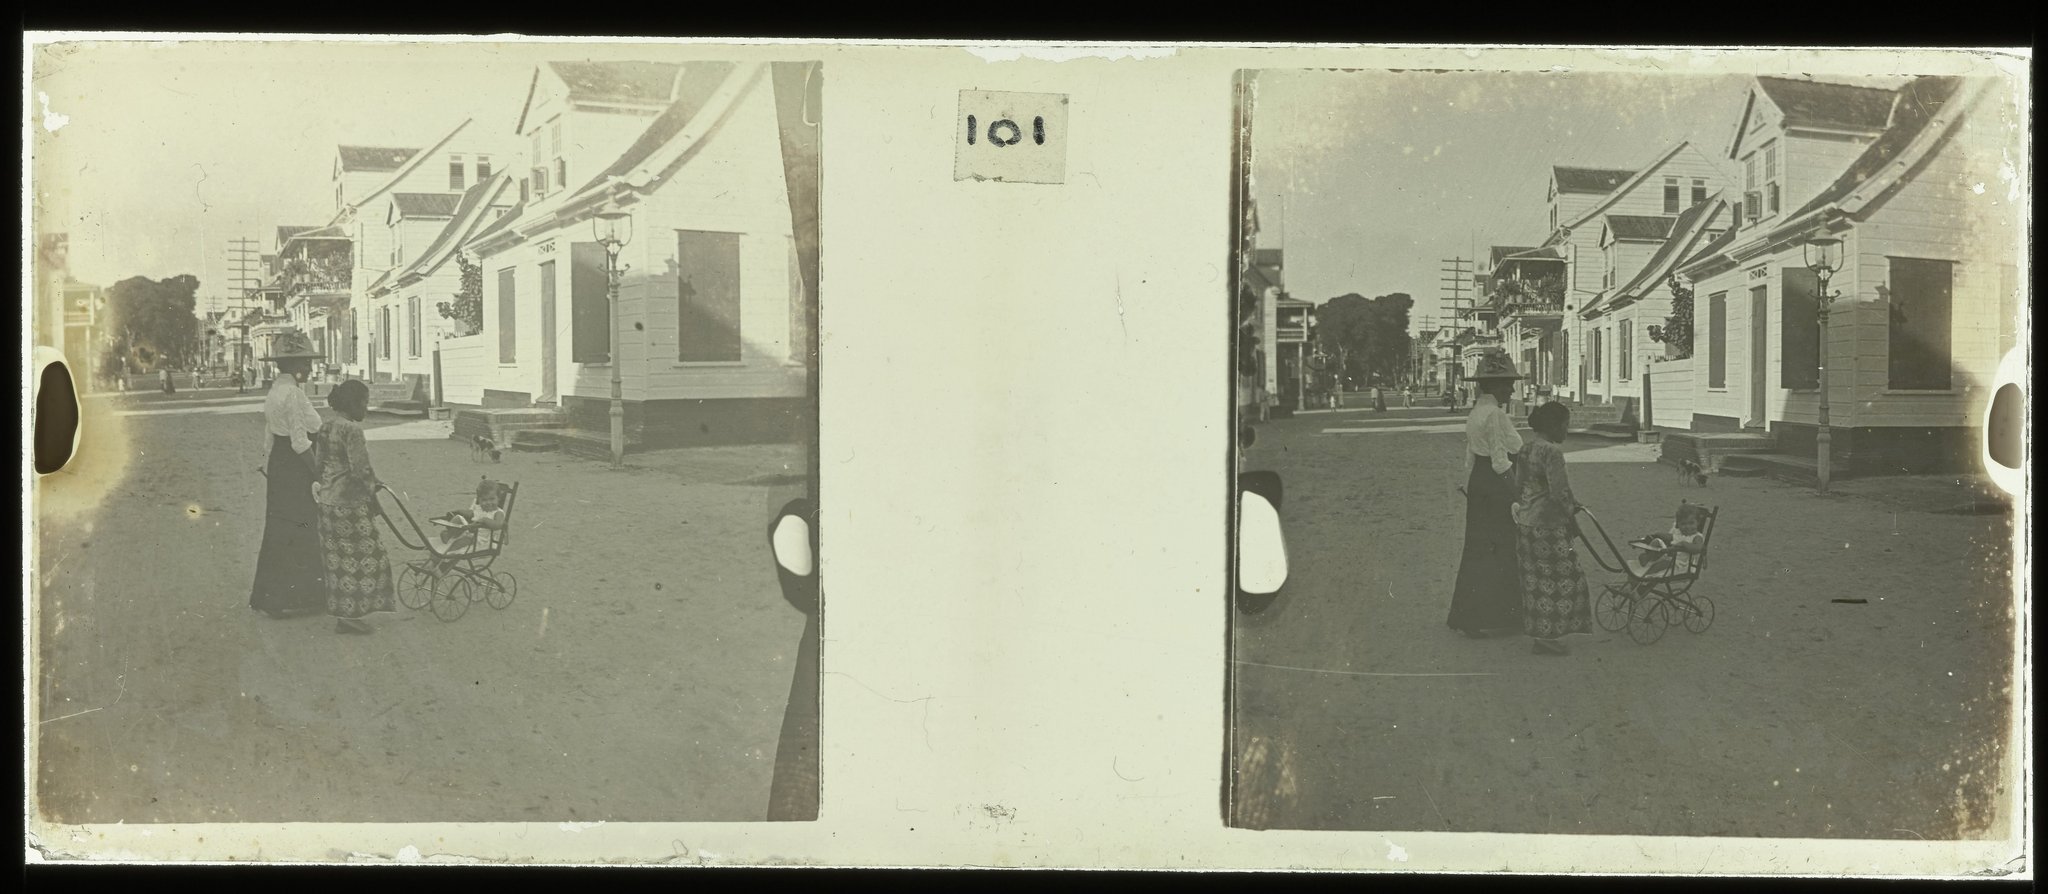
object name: stereograph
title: Lize Brouwers, echtgenote van planter Theodoor Brouwers, met haar zoon Gerard en een Javaanse bediende in Paramaribo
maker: theodoor brouwers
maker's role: amateurfotograaf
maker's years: 1874-1932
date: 1913-1915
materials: glass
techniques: photography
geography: suriname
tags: haarlem, suriname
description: In de periode 1911-1932 woonde op plantage Accaribo in Suriname de familie Brouwers van wie de foto's afkomstig zijn. Rond 1910 vond Theodoor Brouwers werk op plantage Accaribo. In 1929 werd hij eigenaar van de plantage. Op Accaribo werden in zijn tijd bananen geproduceerd en wat koffie.